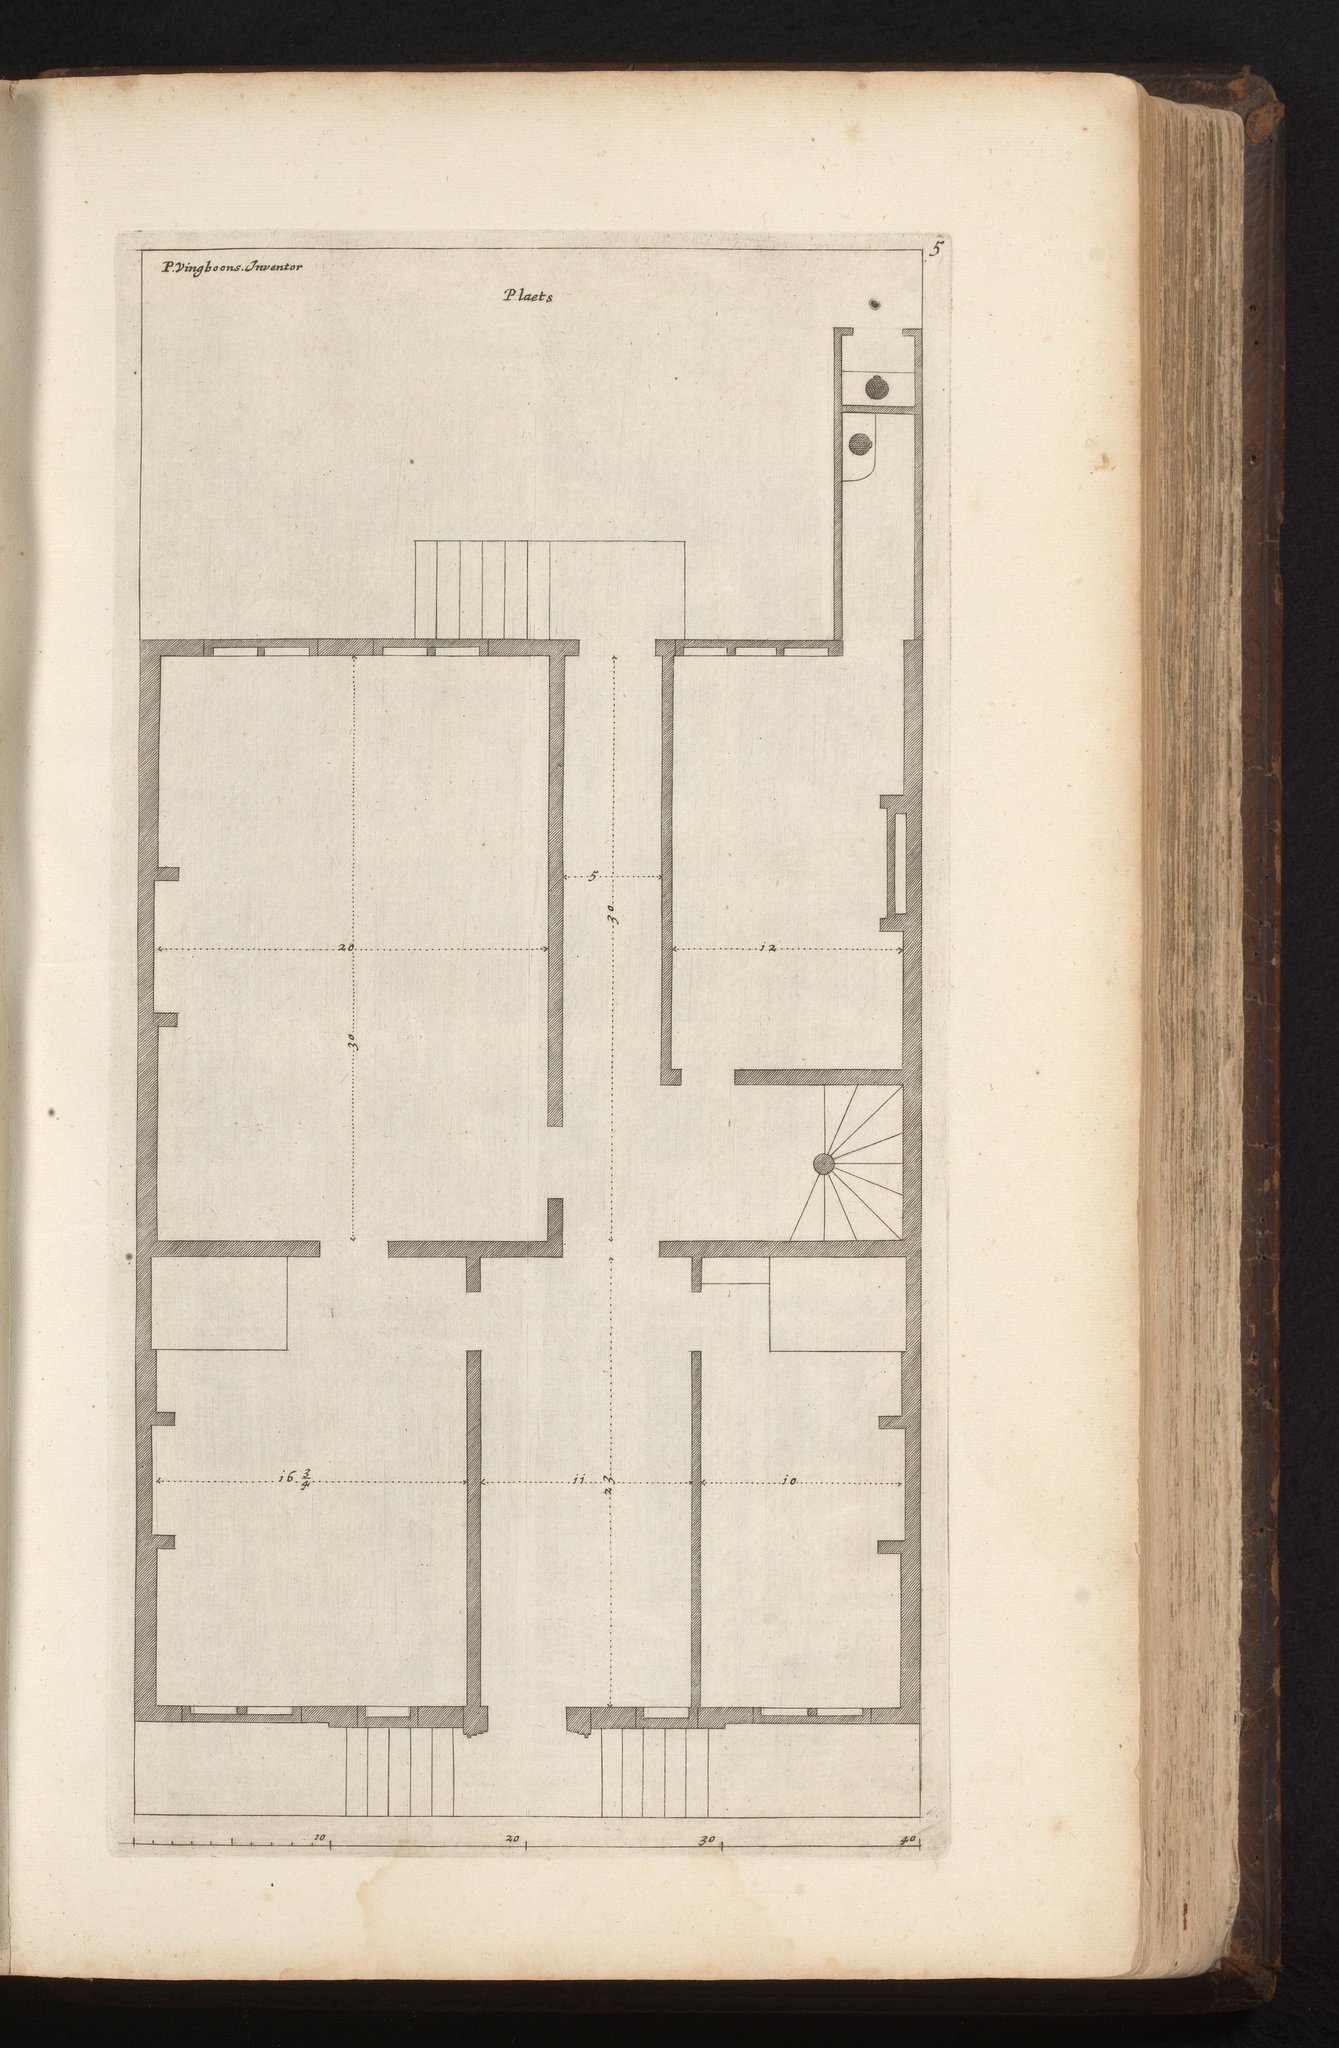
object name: print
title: Plattegrond van een herenhuis aan de Herengracht te Amsterdam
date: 1648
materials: paper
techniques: engraving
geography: amsterdam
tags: plan ~ architecture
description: Prent uit: Afbeelsels der voornaemste gebouwen uyt alle die Philips Vingboons geordineert heeft. Amsterdam: Philips en Johannes Vinckboons en Johannes Willemszoon Blaeu, 1648.